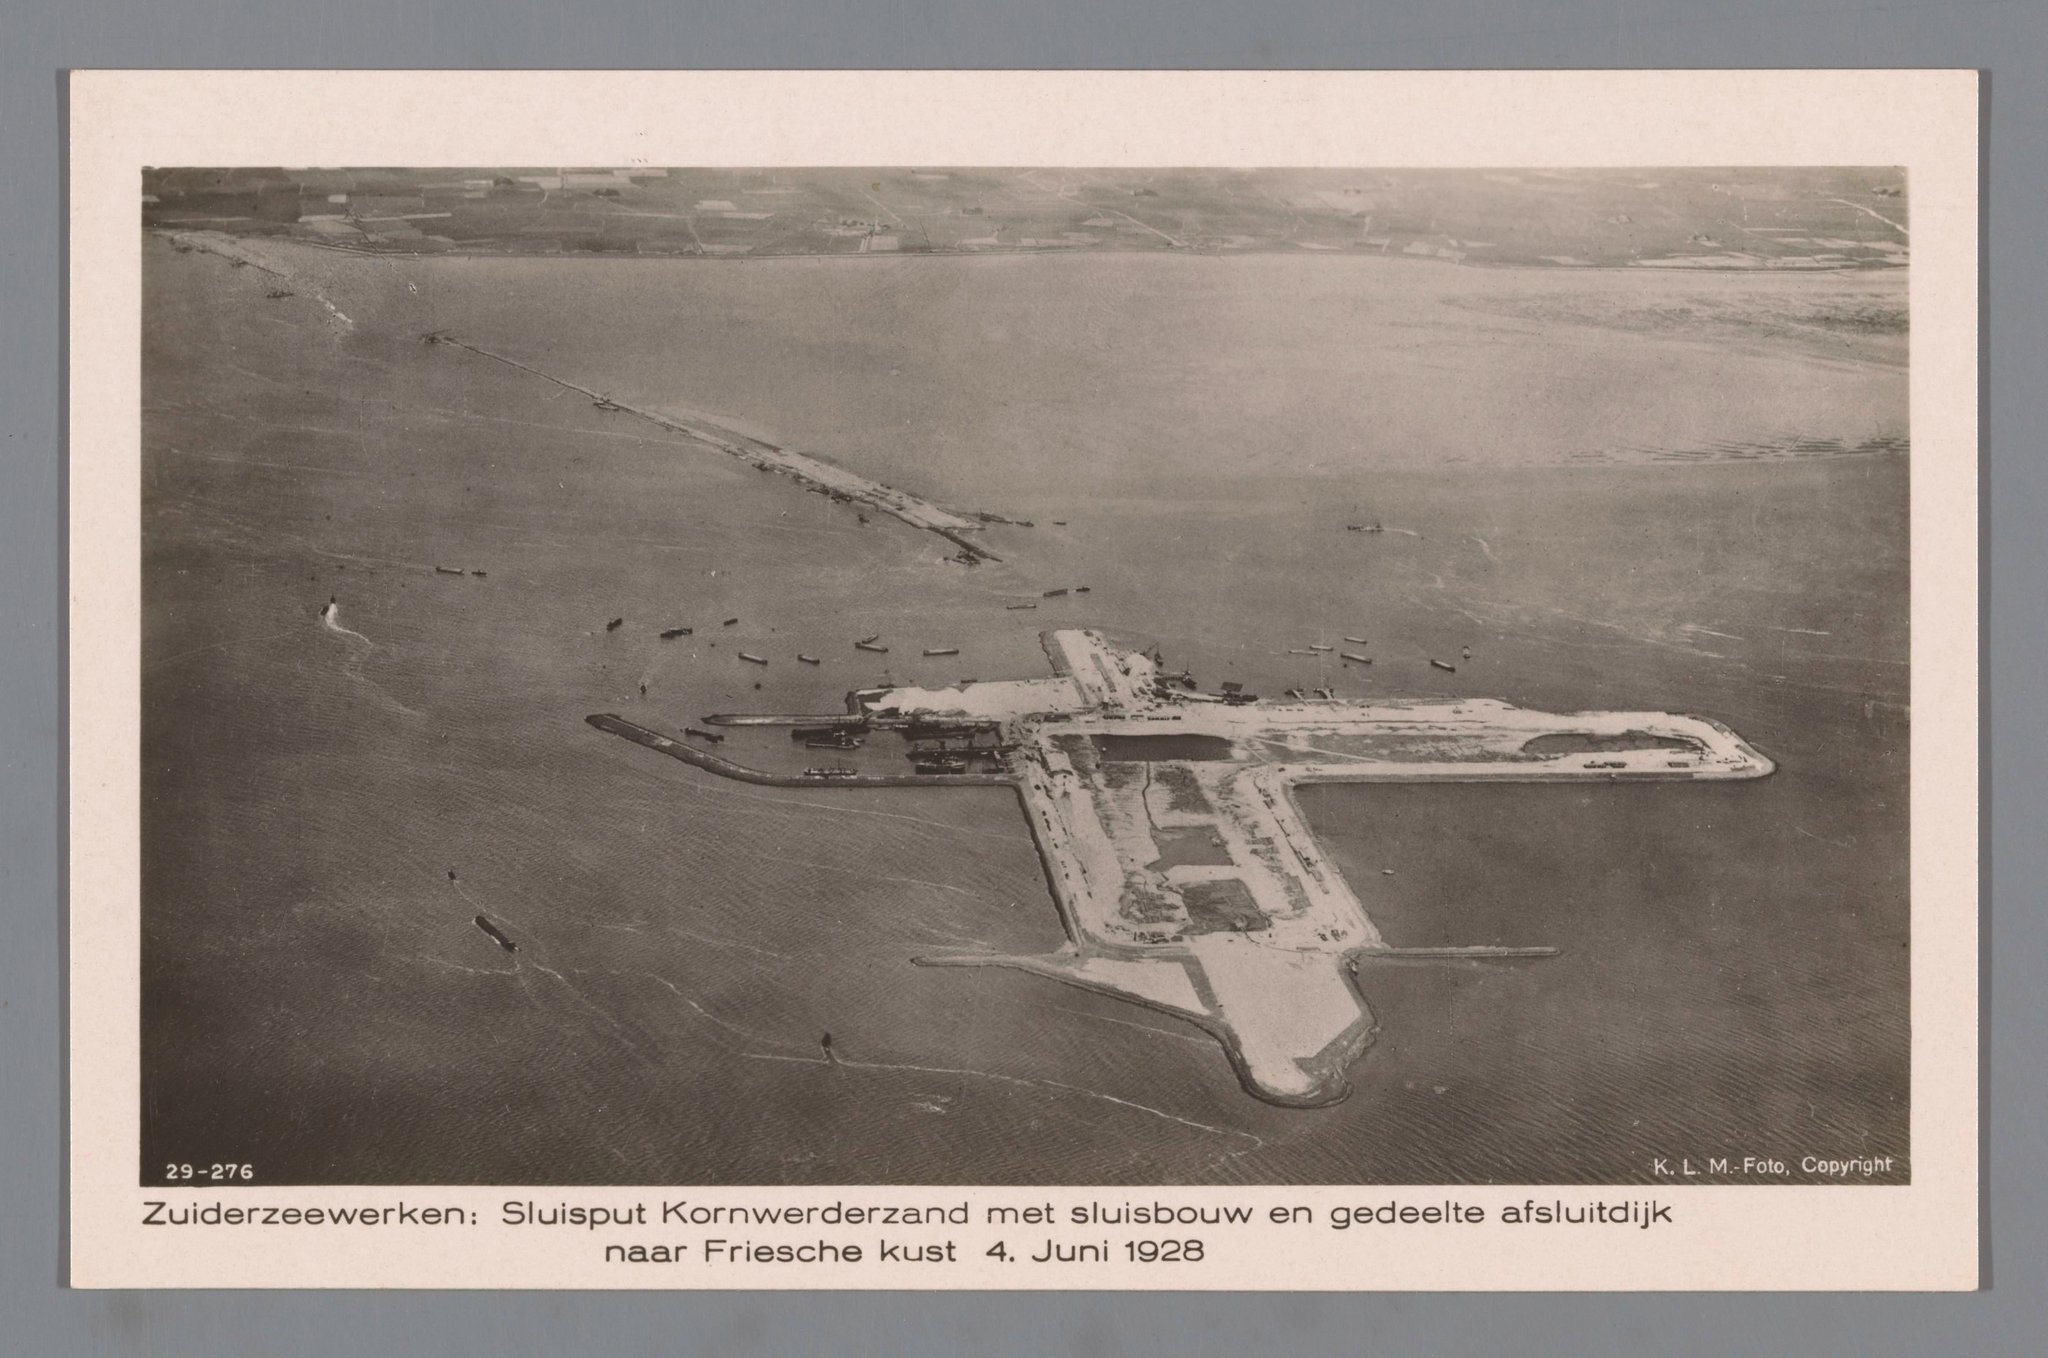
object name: ansichtkaart, prentbriefkaart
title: Zuiderzeewerken: Sluisput Kornwerderzand met sluisbouw en gedeelte afsluitdijk naar de Friesche kust 10 mei 1928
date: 1928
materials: cardboard, photographic support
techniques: gelatin silver print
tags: draining for land reclamation, zuiderzee